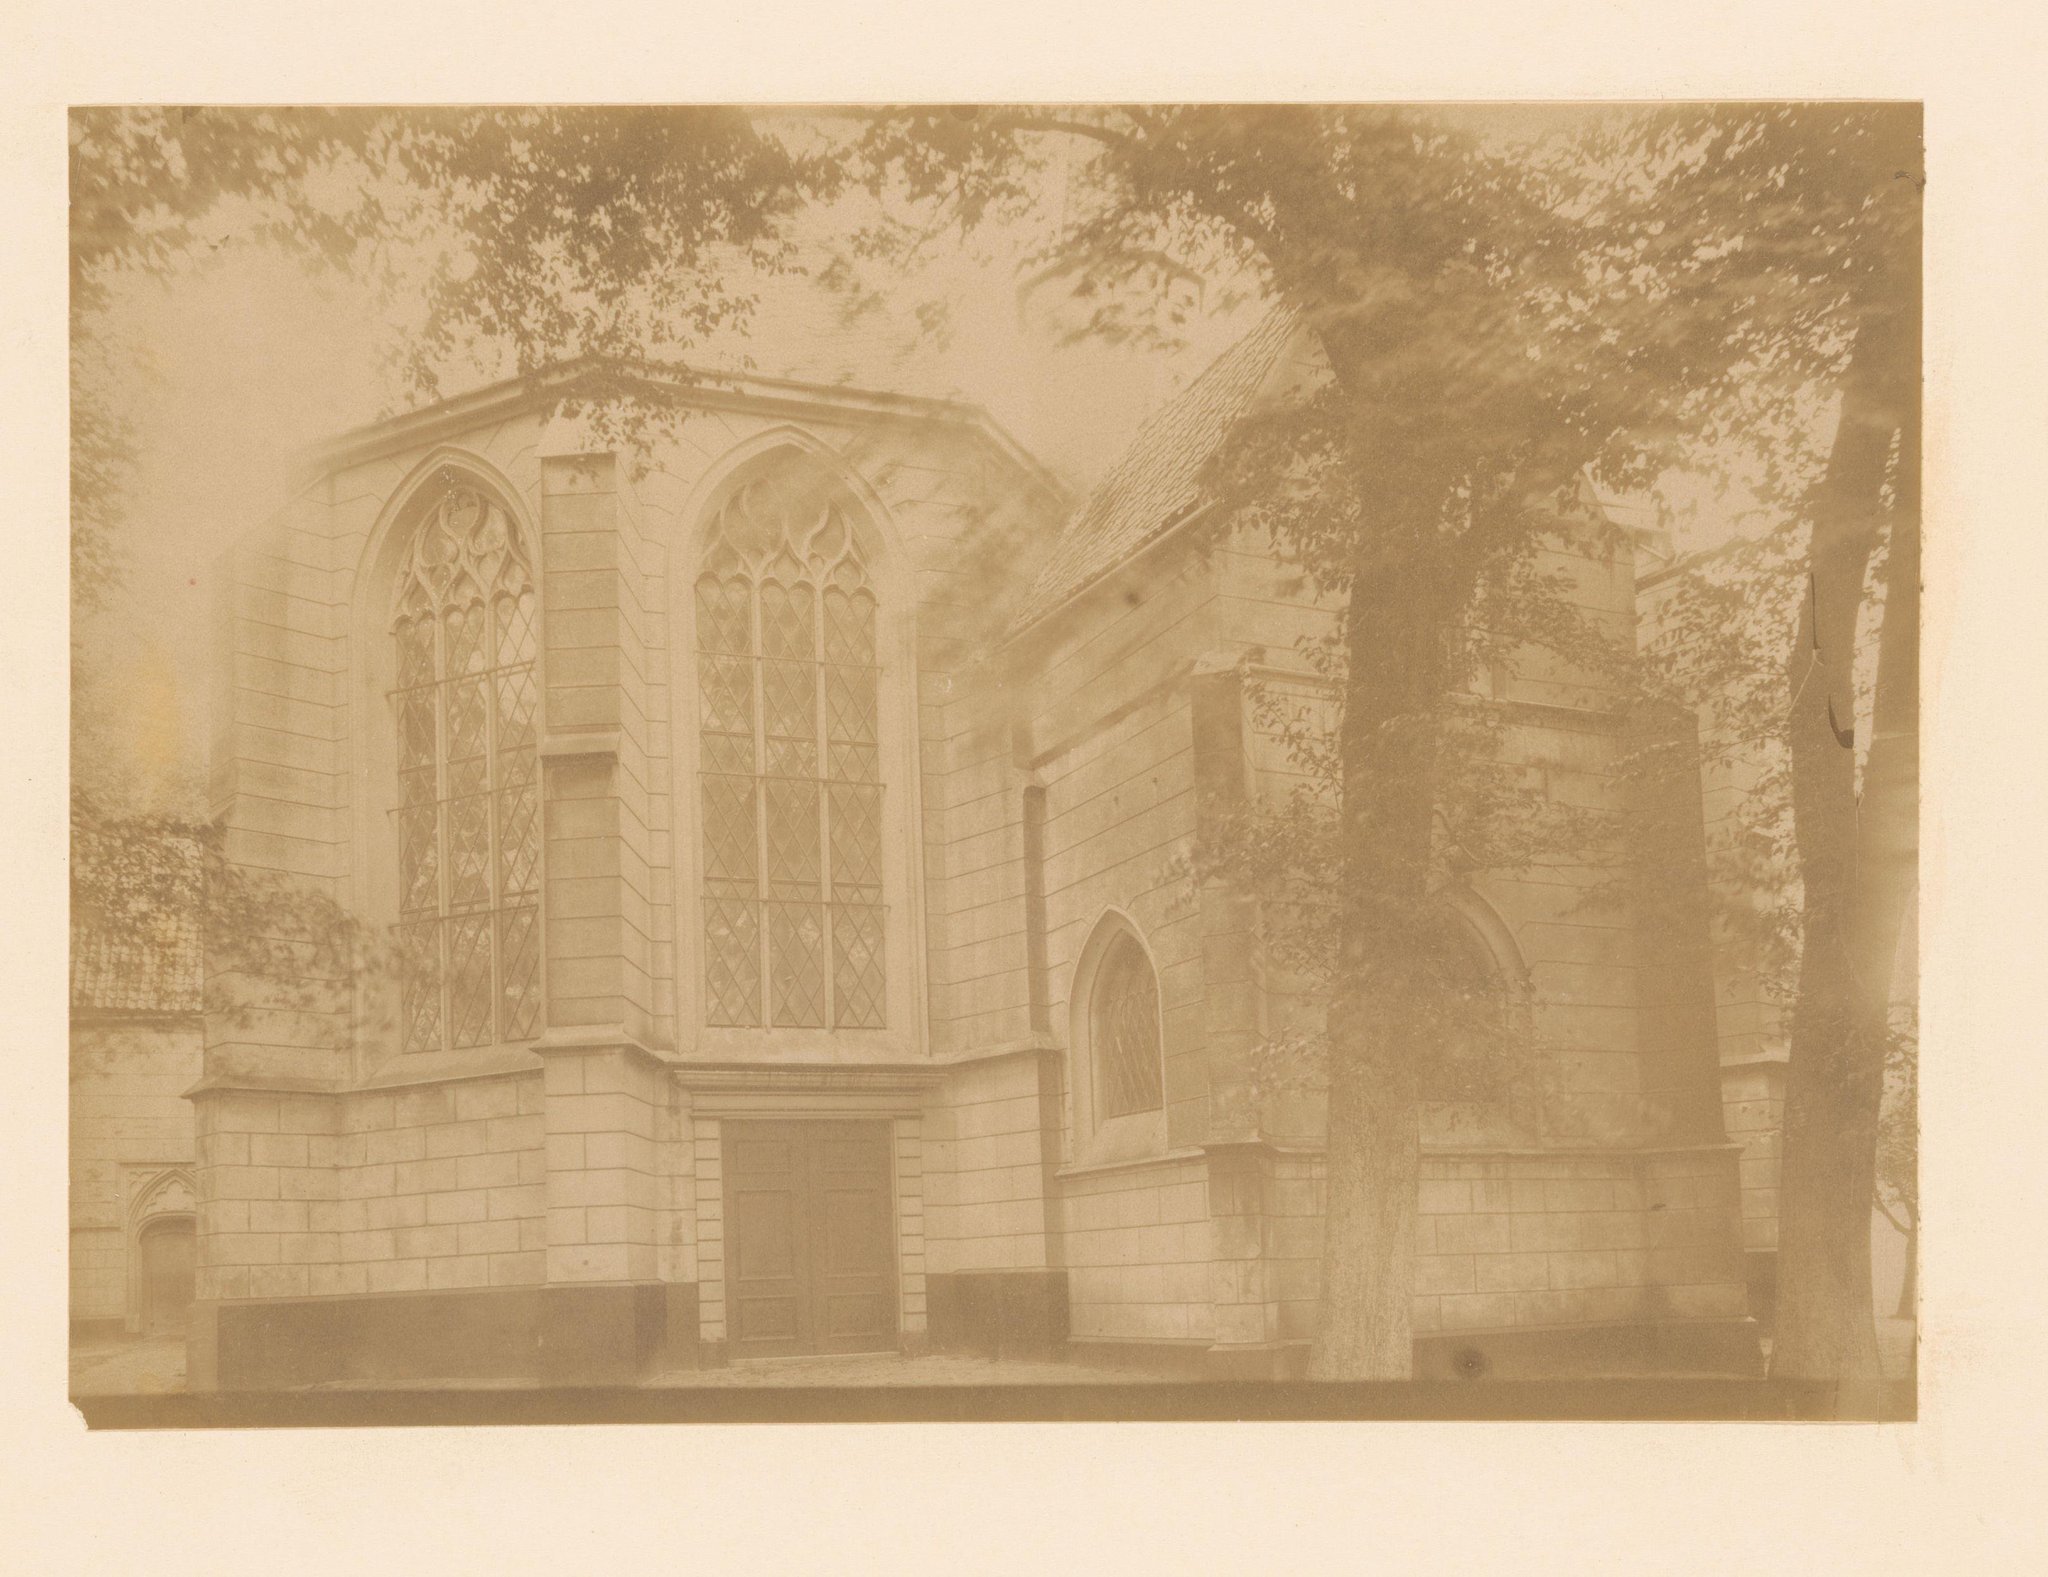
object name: photograph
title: Gedeelte van de Hervormde Kerk te IJsselmuiden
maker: anoniem (monumentenzorg)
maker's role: fotograaf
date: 1893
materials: cardboard, photographic support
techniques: albumen print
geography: ijsselmuiden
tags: church (exterior)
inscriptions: annotation: ‘IJselmuiden’, annotation: ‘IJselmuiden bij Kampen (O.IJ.) Kerk v/d N.H. gemeente/ sept 1893’